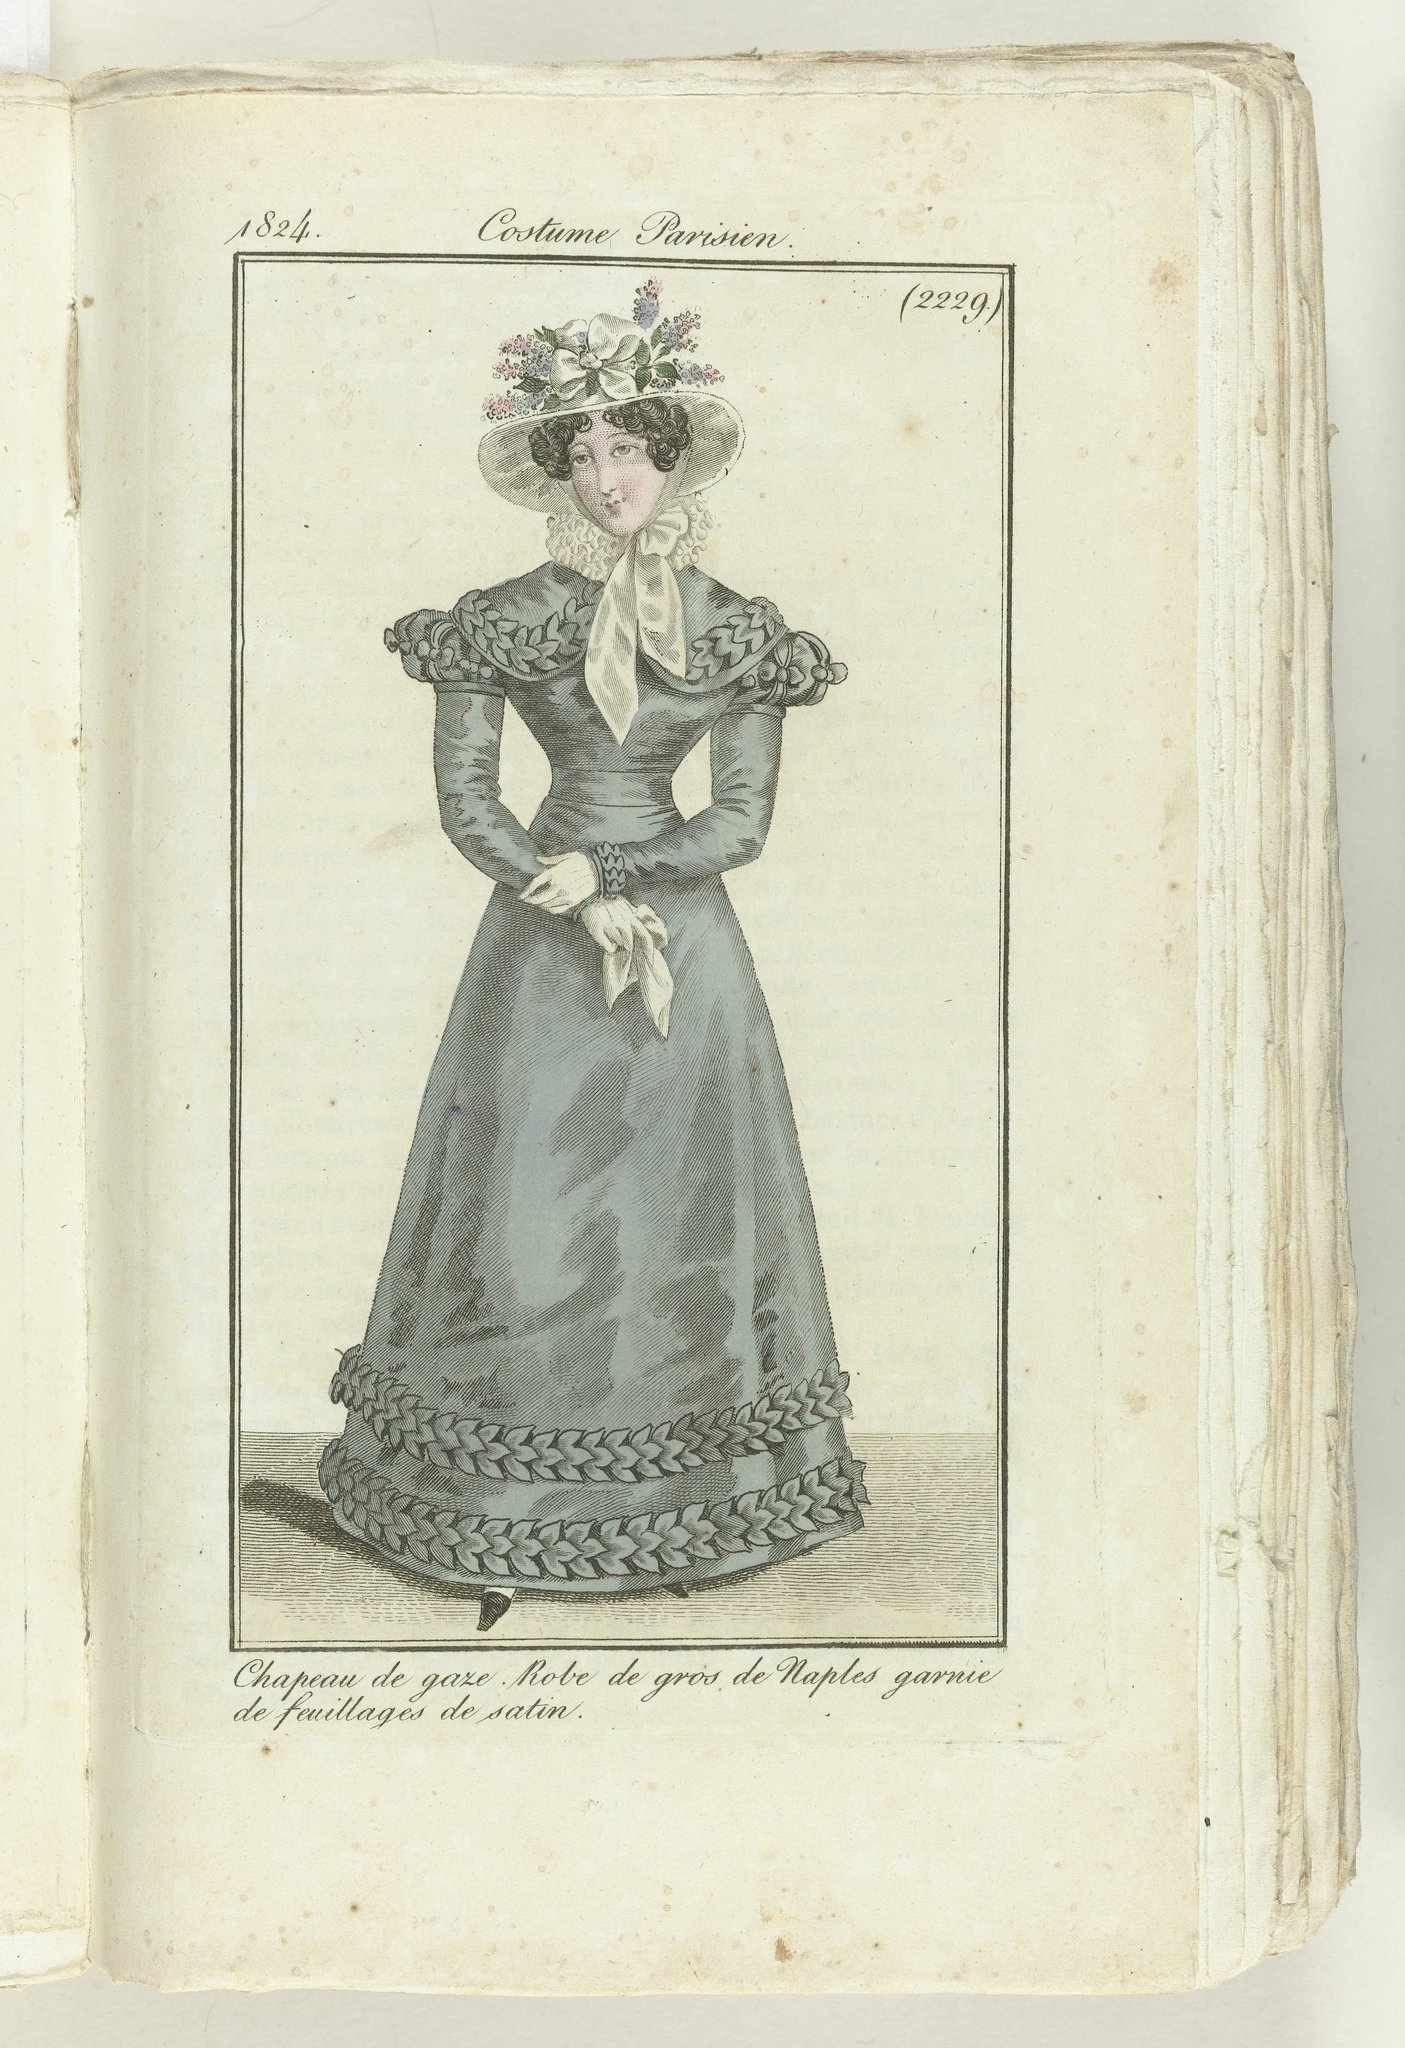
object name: fashion print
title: Journal des Dames et des Modes 1824, Costume Parisien (2229)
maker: Anonymous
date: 1824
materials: paper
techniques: etching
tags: fashion plates, clothes, costume (+ women's clothes)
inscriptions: date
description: Prent uit het tijdschrift Journal des Dames et des Modes, 1824.